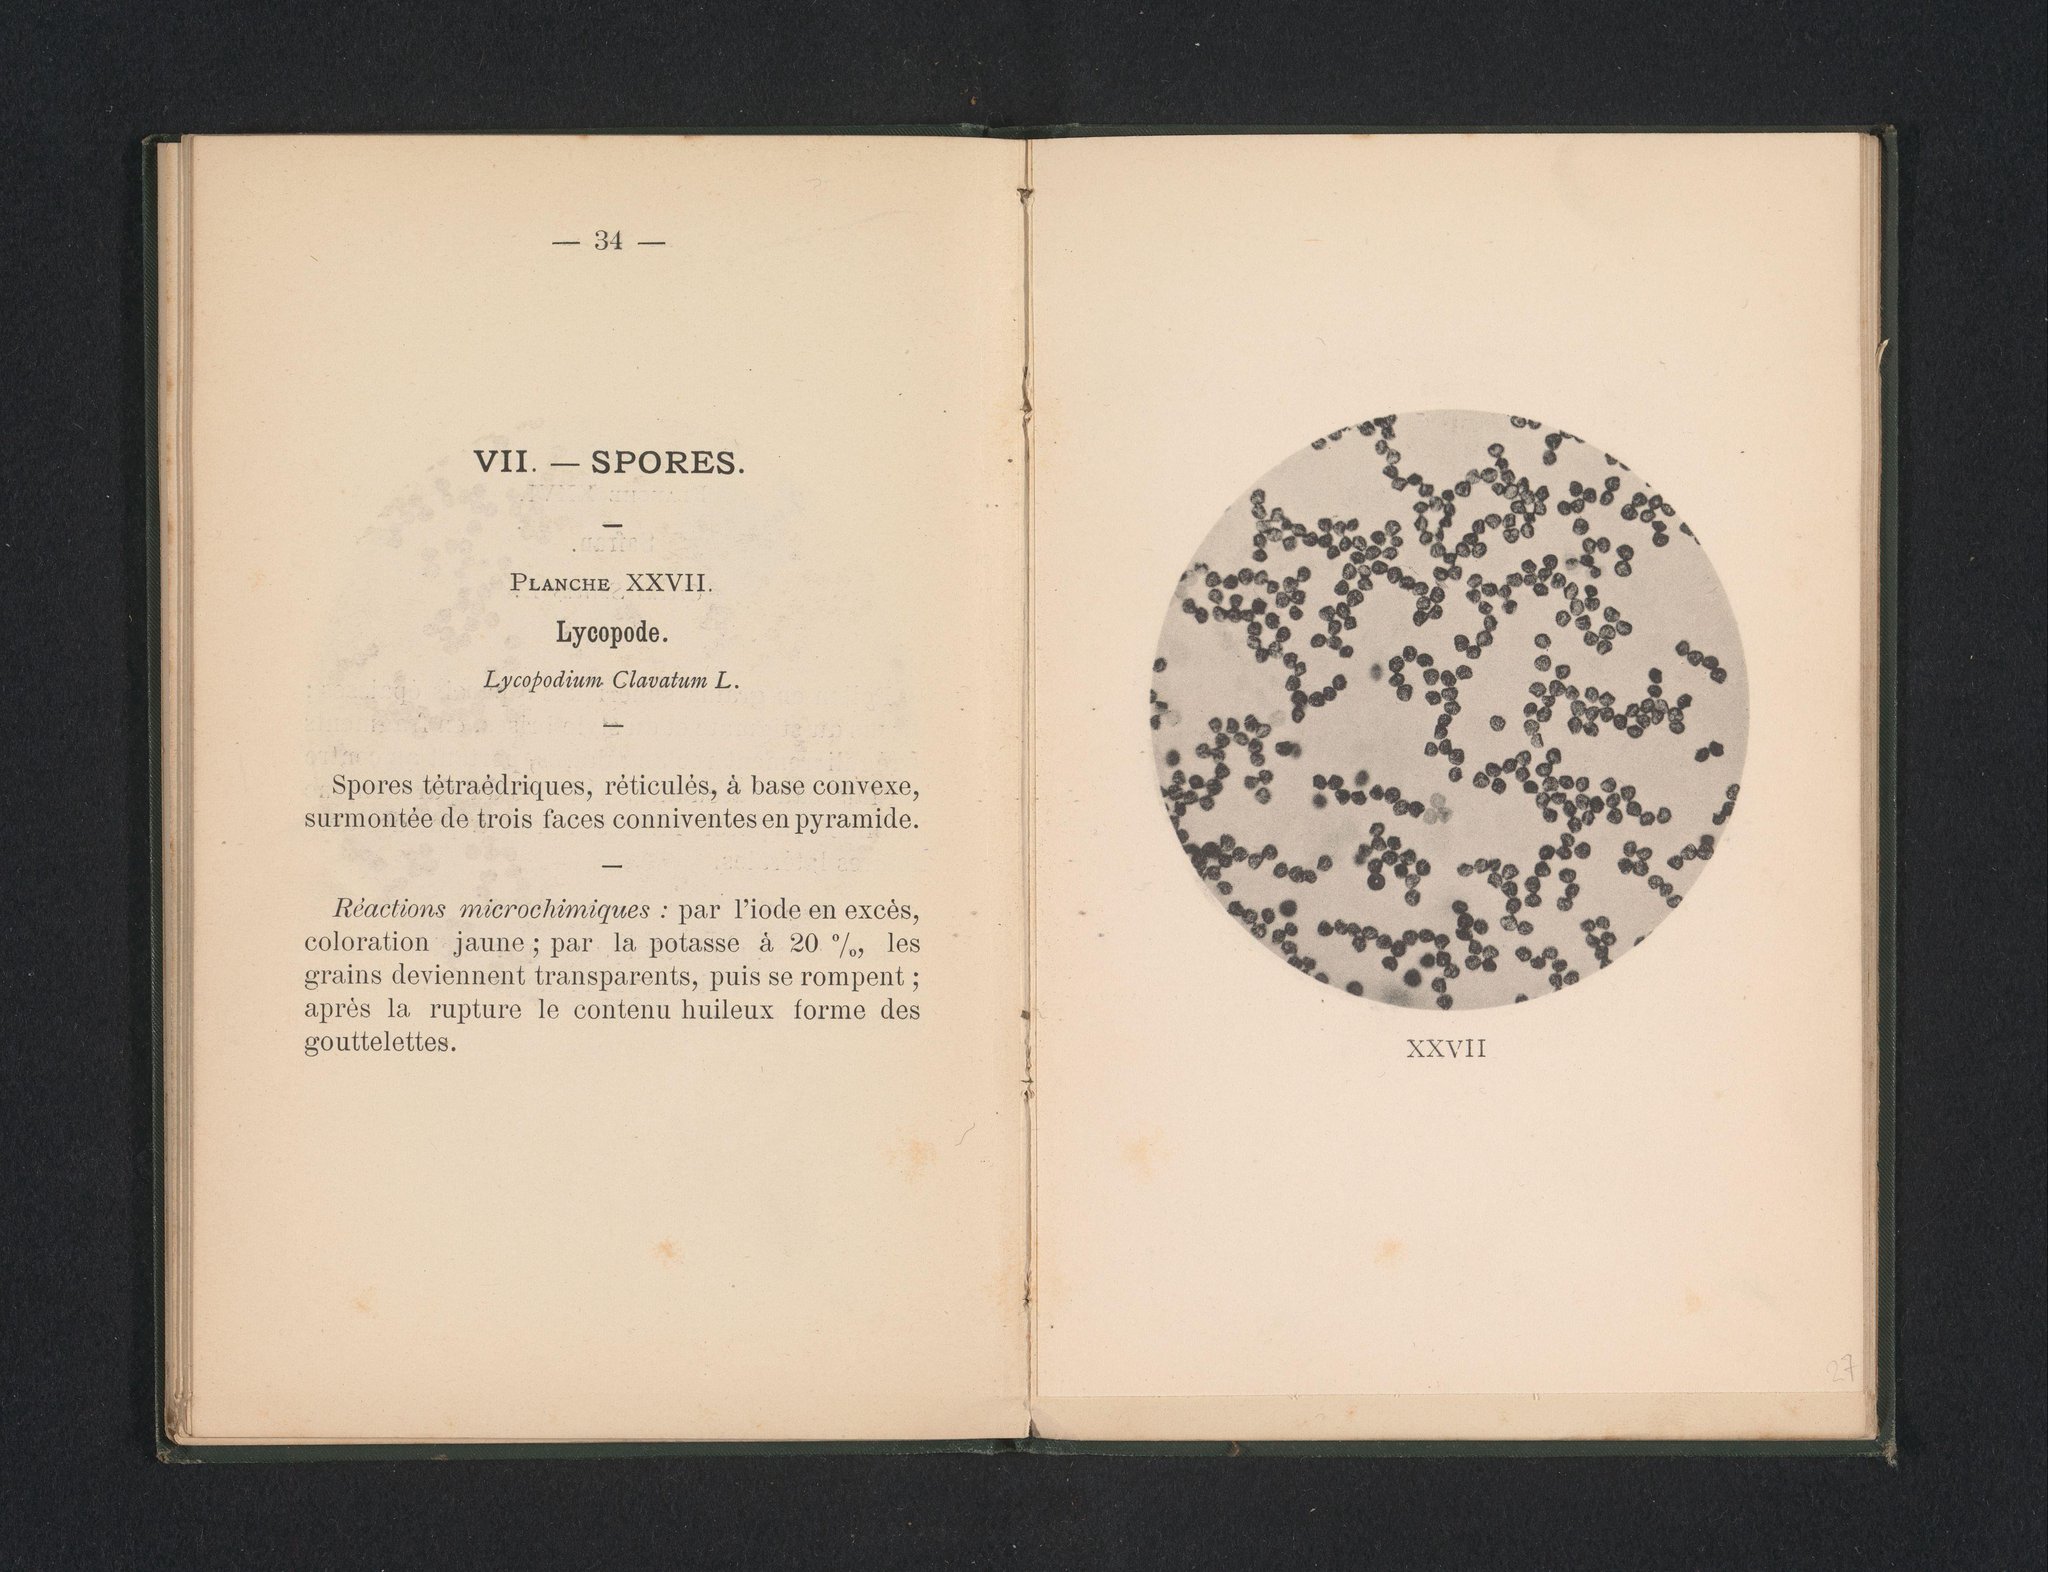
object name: photomechanical print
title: Microscopische weergave van grote wolfsklauw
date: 1891-1896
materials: paper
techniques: photograph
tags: microscope (+ scientific research)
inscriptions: number: ‘XXVII’